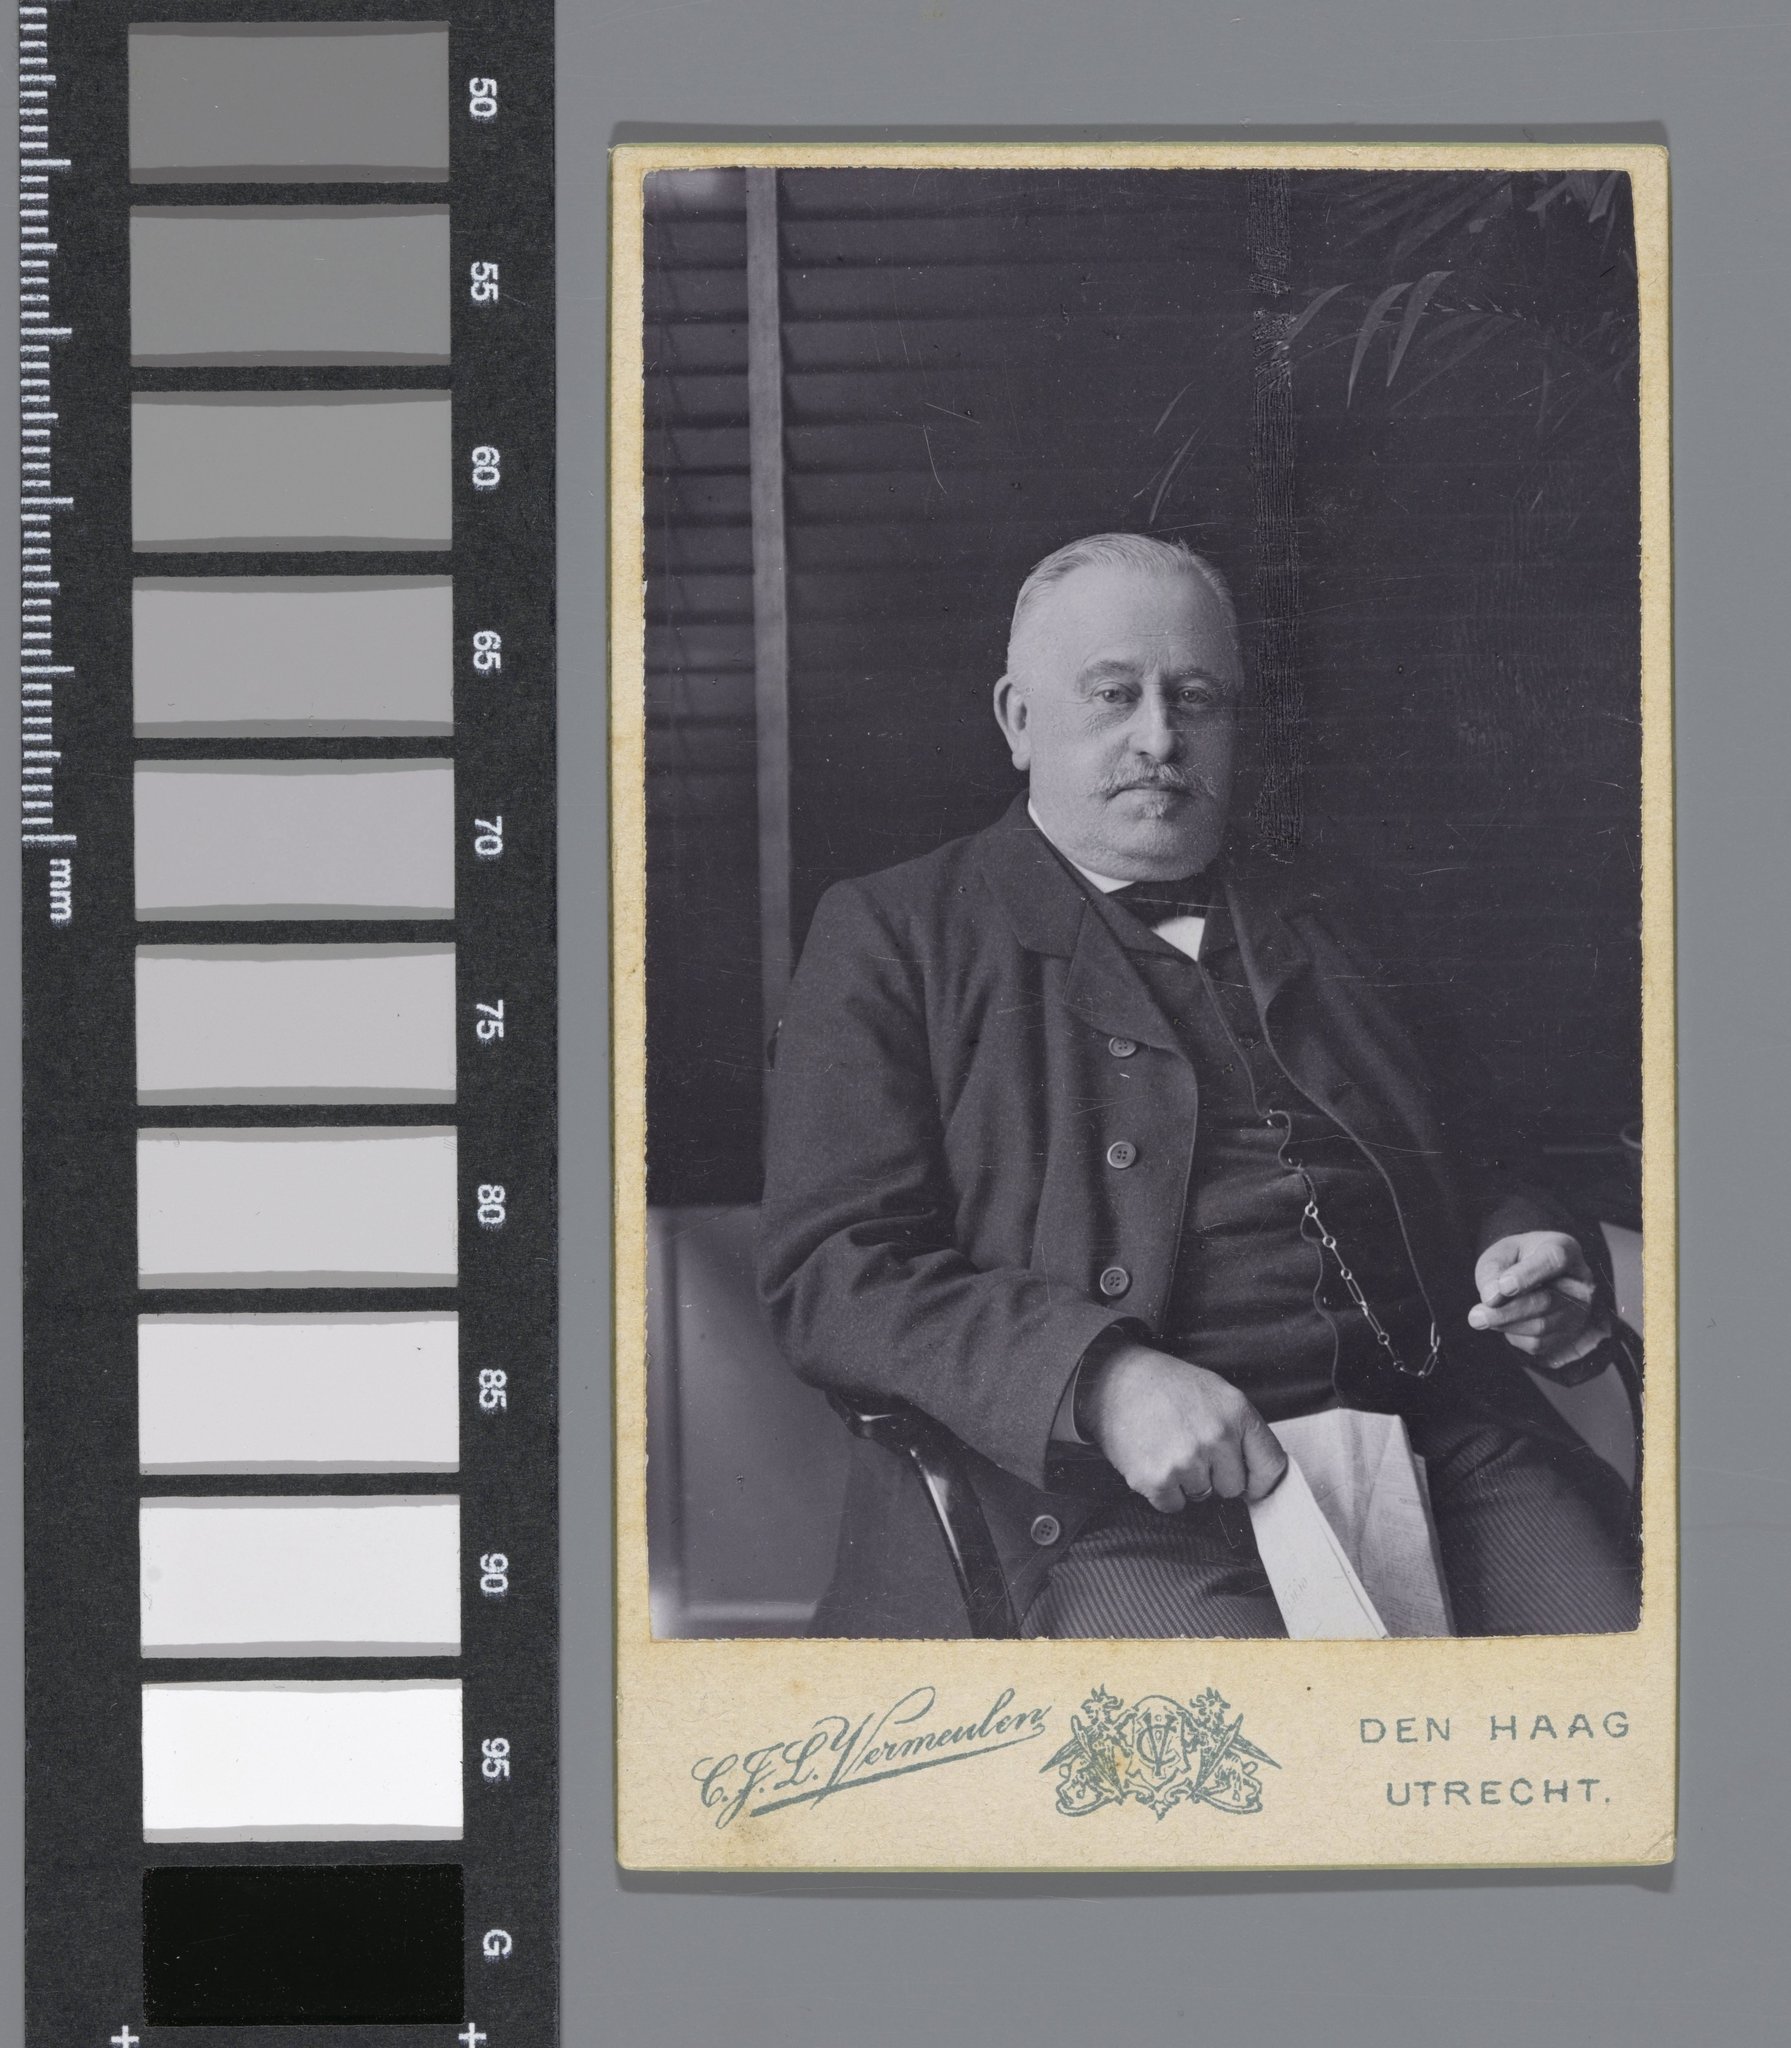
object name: photograph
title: Portret van J.B. Groenewegen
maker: cornelis johannes lodewicus vermeulen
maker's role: fotograaf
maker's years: 1861-1936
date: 1907-1910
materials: cardboard, paper, photographic support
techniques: collodion silver print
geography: the hague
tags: historical persons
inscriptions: signature: ‘C.J.L. Vermeulen, Den Haag, Utrecht.’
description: De Carte de visite is onderdeel van de groep foto's A.J. Nijland.